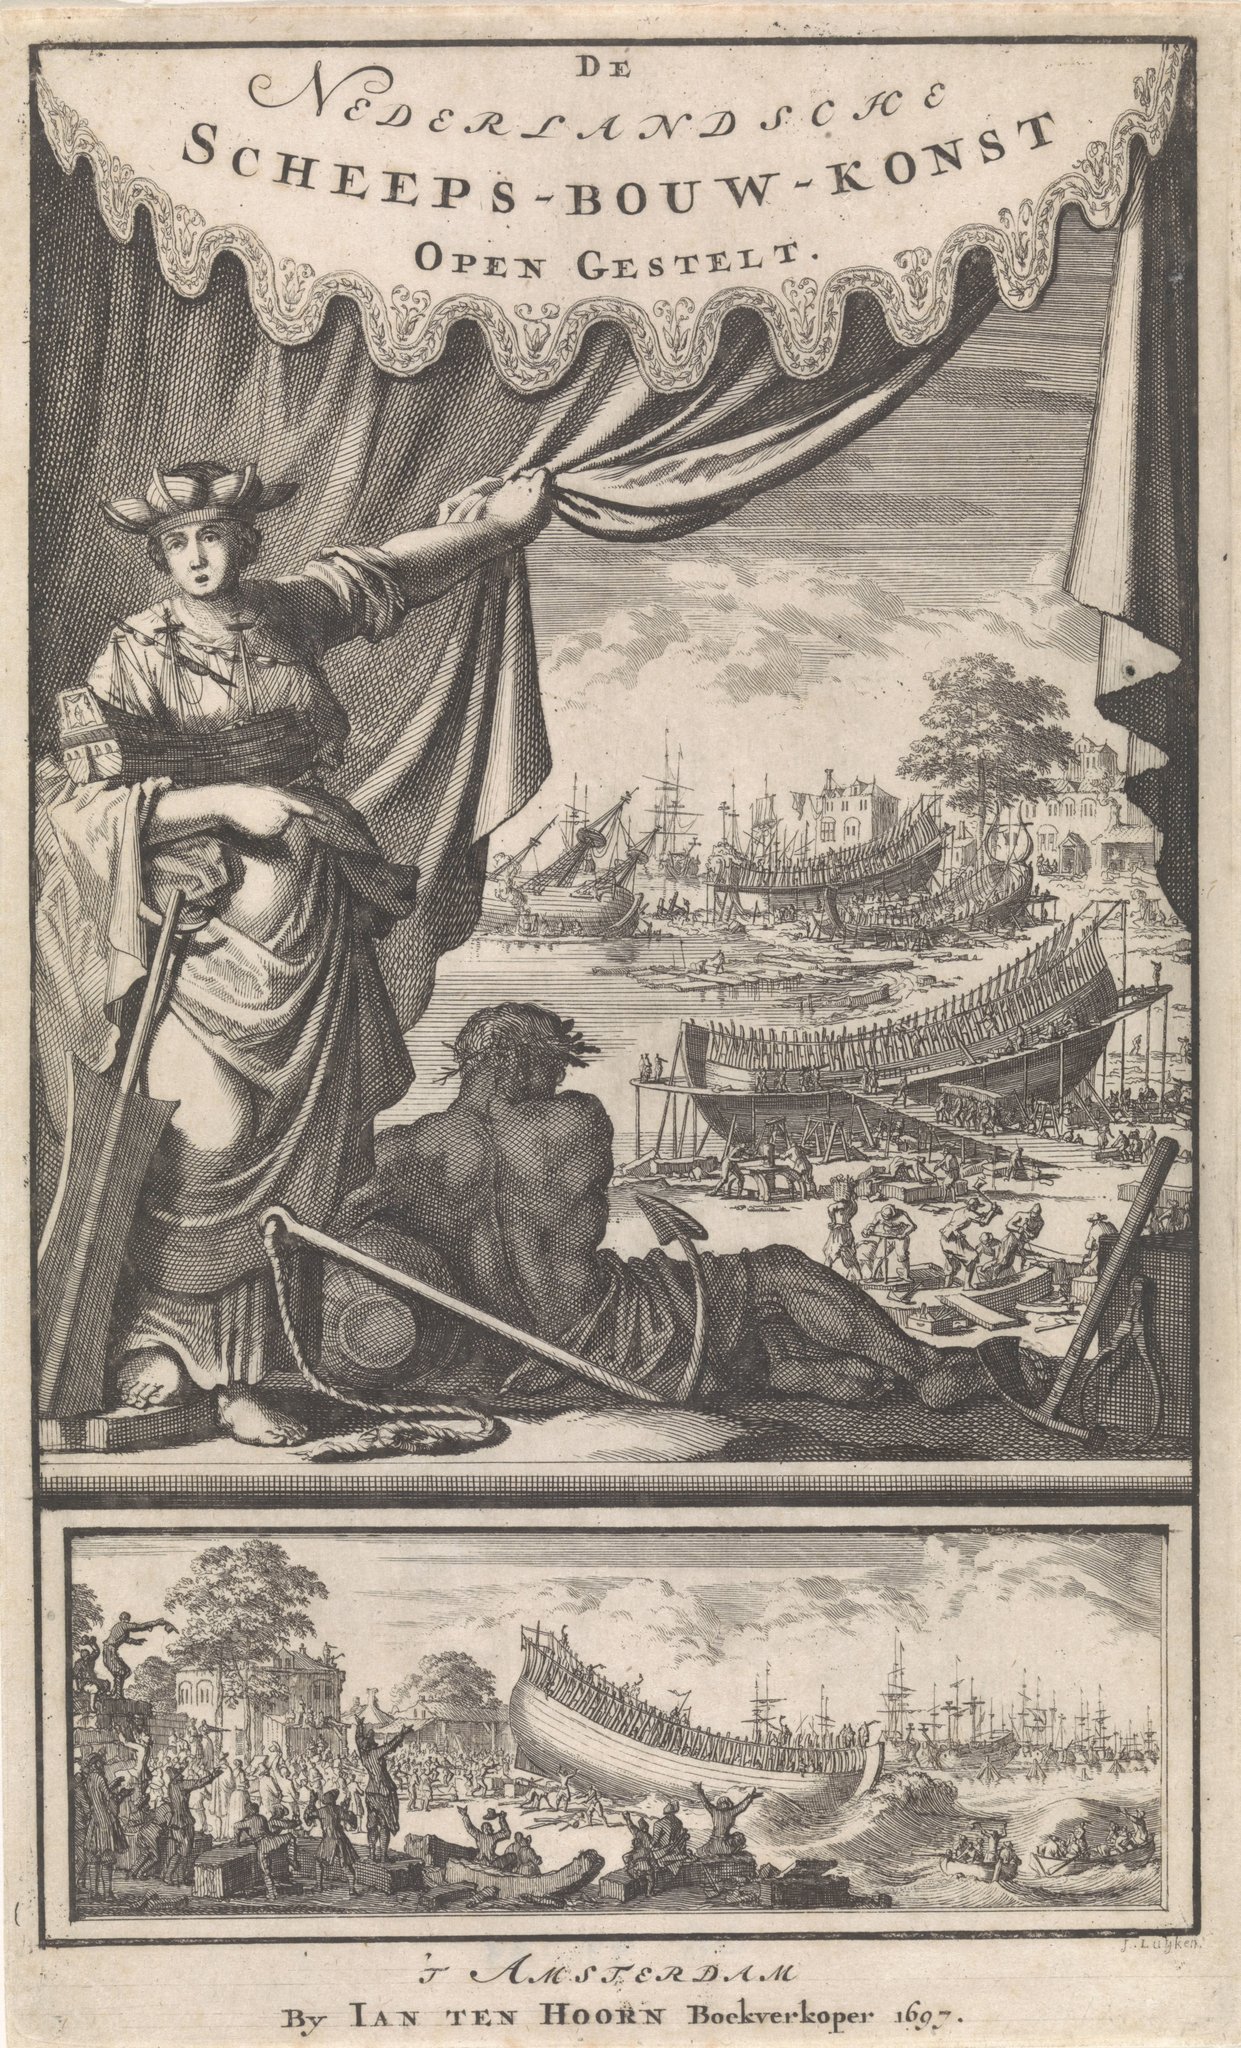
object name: print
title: Scheepvaart toont een scheepswerf in volle werking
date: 1697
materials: paper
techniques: etching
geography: delft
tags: river-gods, launching a ship, shipyard, shipdock - cc - more than one ship, 'navigatione' (ripa)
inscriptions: collector's mark: Lugt 789, collector's mark: Lugt 2228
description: De personificatie van de Scheepvaart schuift een gordijn opzij om een scheepswerf in volle werking te tonen. De Scheepvaart is gekroond met een scheepskroon en draagt een model van een schip in haar armen. Aan haar voeten ligt een riviergod. Op een afzonderlijk omlijnd gedeelte hieronder is het van stapel lopen van een schip weergegeven.